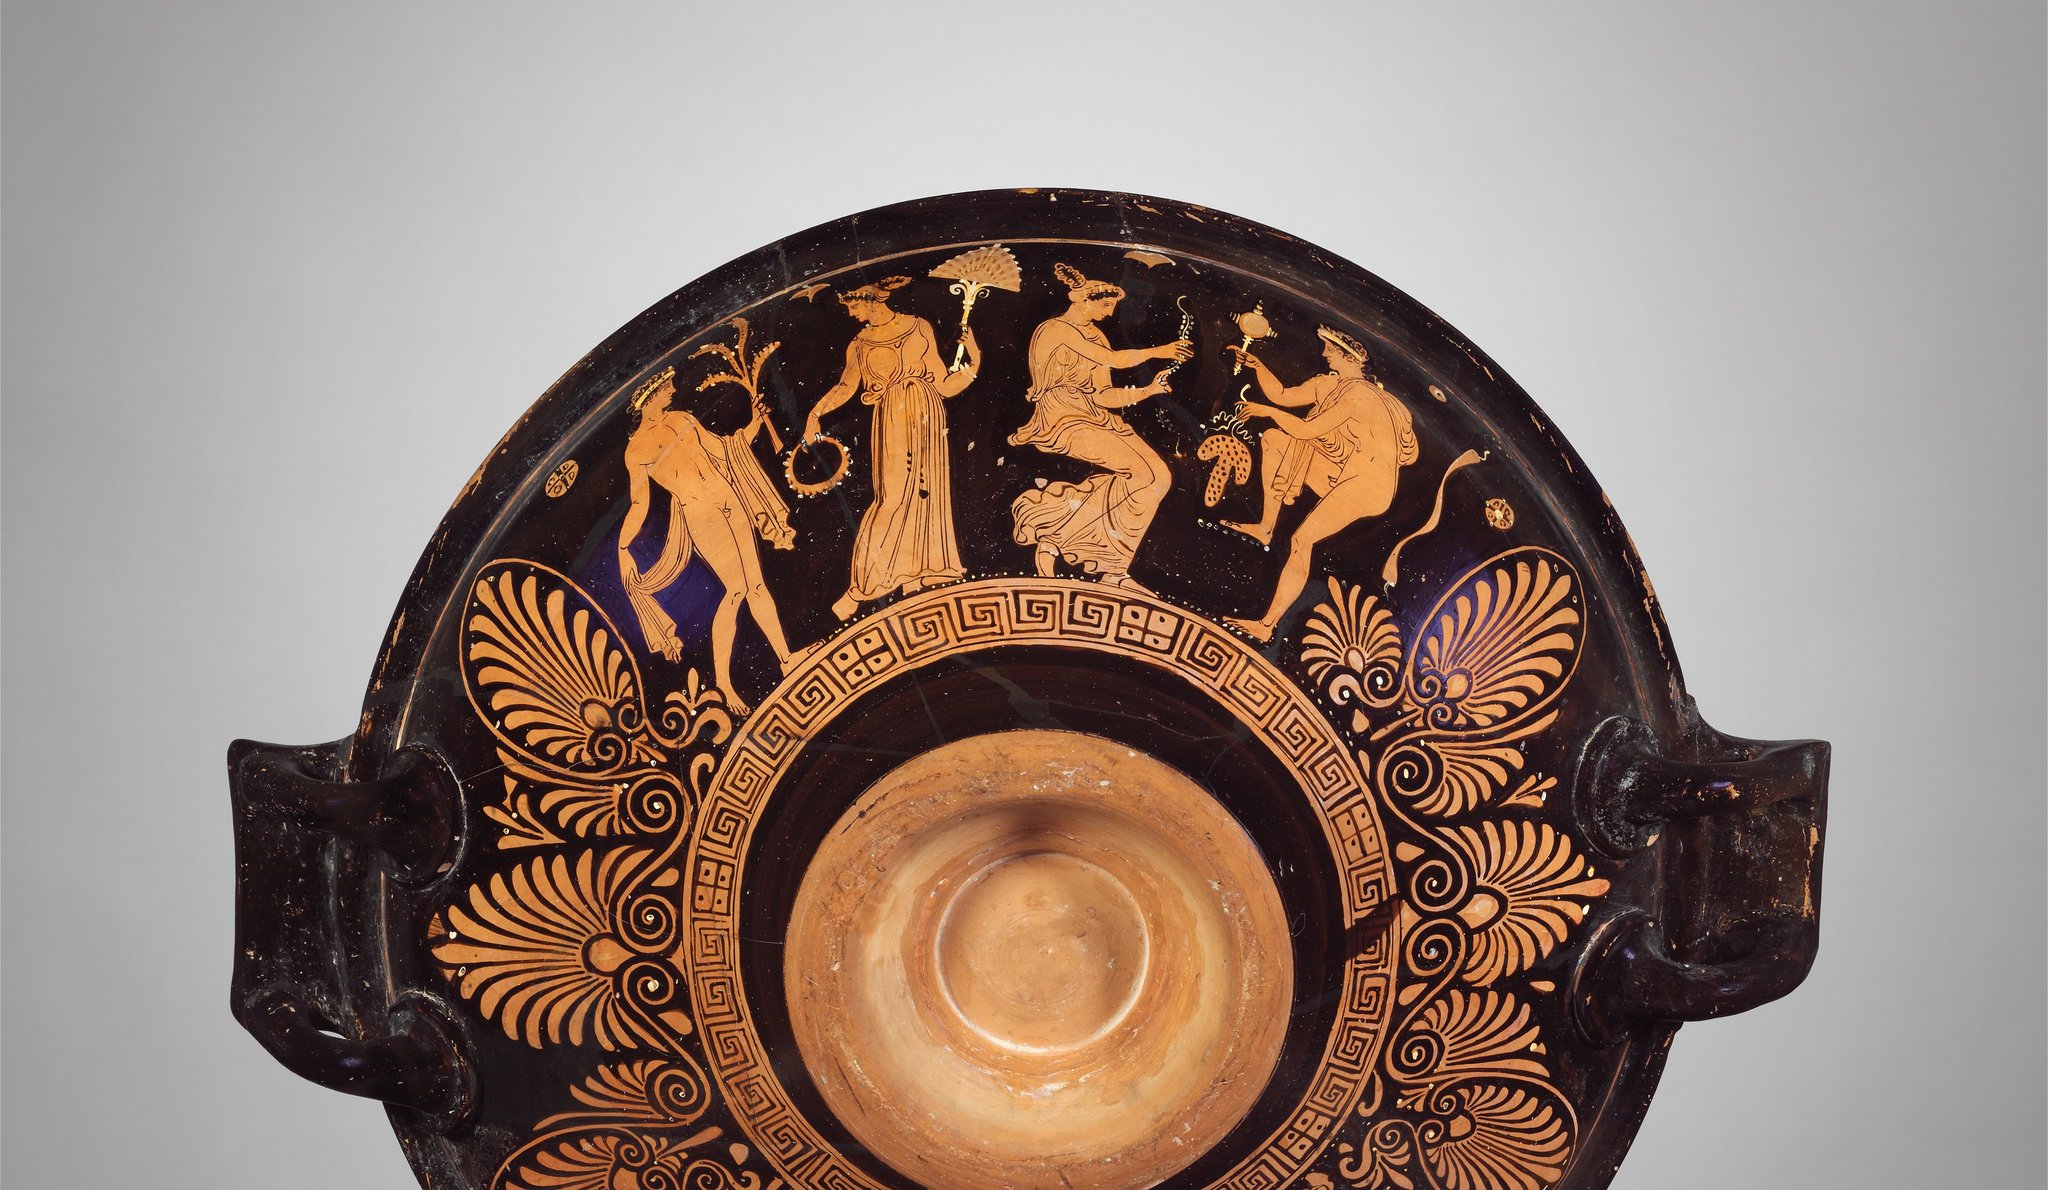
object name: lekanis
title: Terracotta lekanis (dish)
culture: greek, south italian, apulian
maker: v. and a. group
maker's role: artist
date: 365-350 BCE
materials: terracotta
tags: male nudes,women,eros,griffins